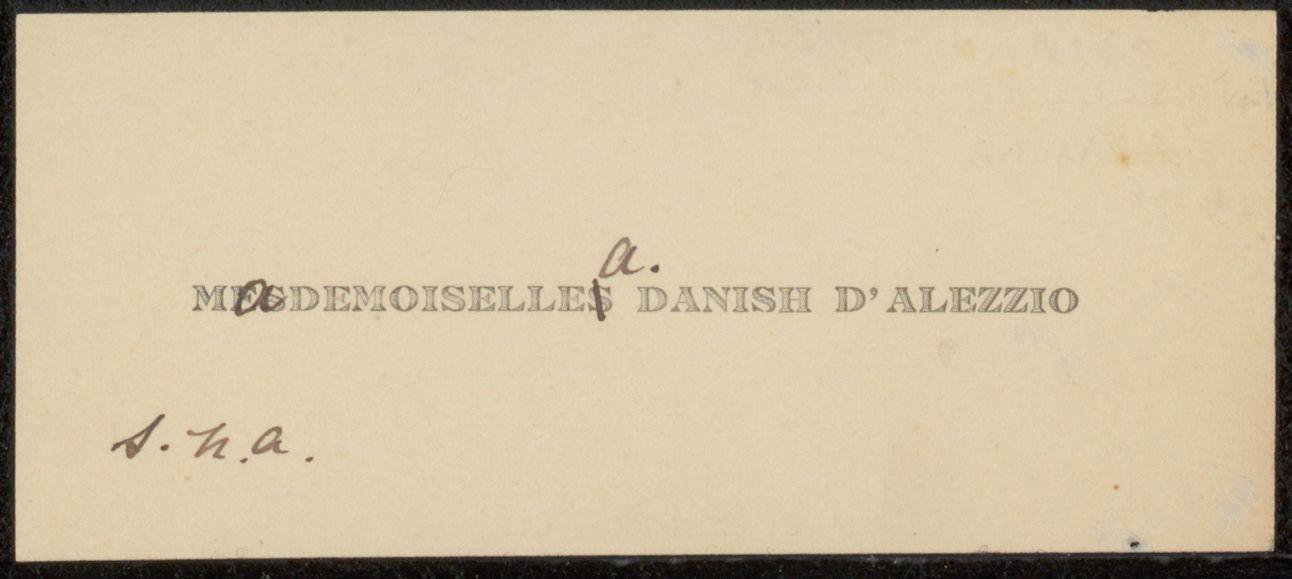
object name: visiting card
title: Visitekaartje aan Philip Zilcken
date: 1867-1930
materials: cardboard, ink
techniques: pen, printing, writing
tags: the hague, painter, draughtsman, philip zilcken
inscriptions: collector's mark: ‘RPK’